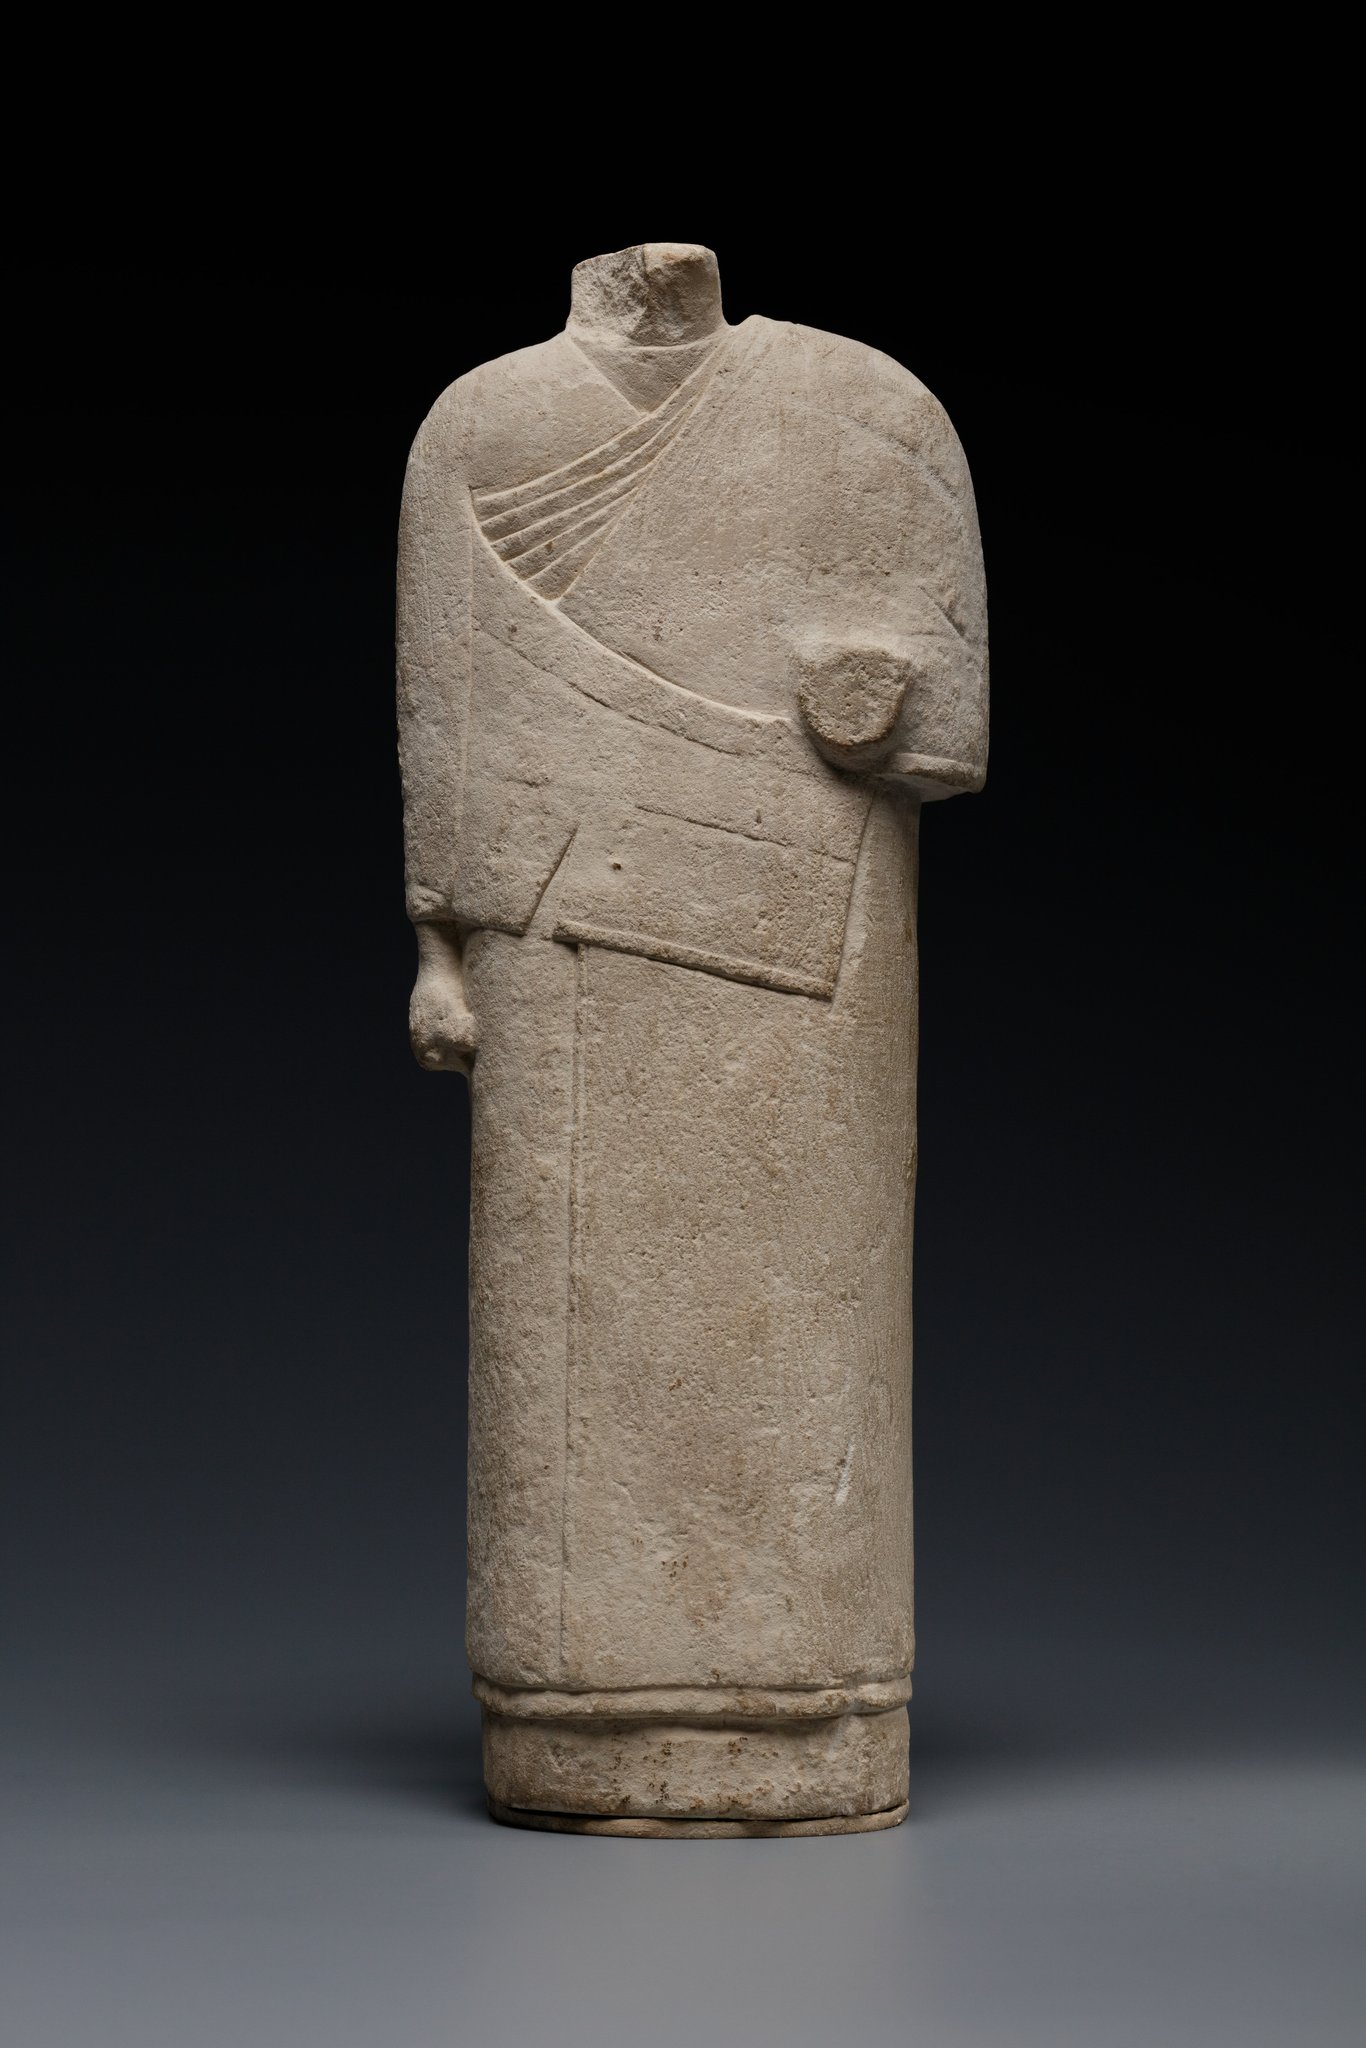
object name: sculptor's model votive, draped costume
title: Incomplete figure in draped costume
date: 400-301 BCE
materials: limestone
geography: egypt